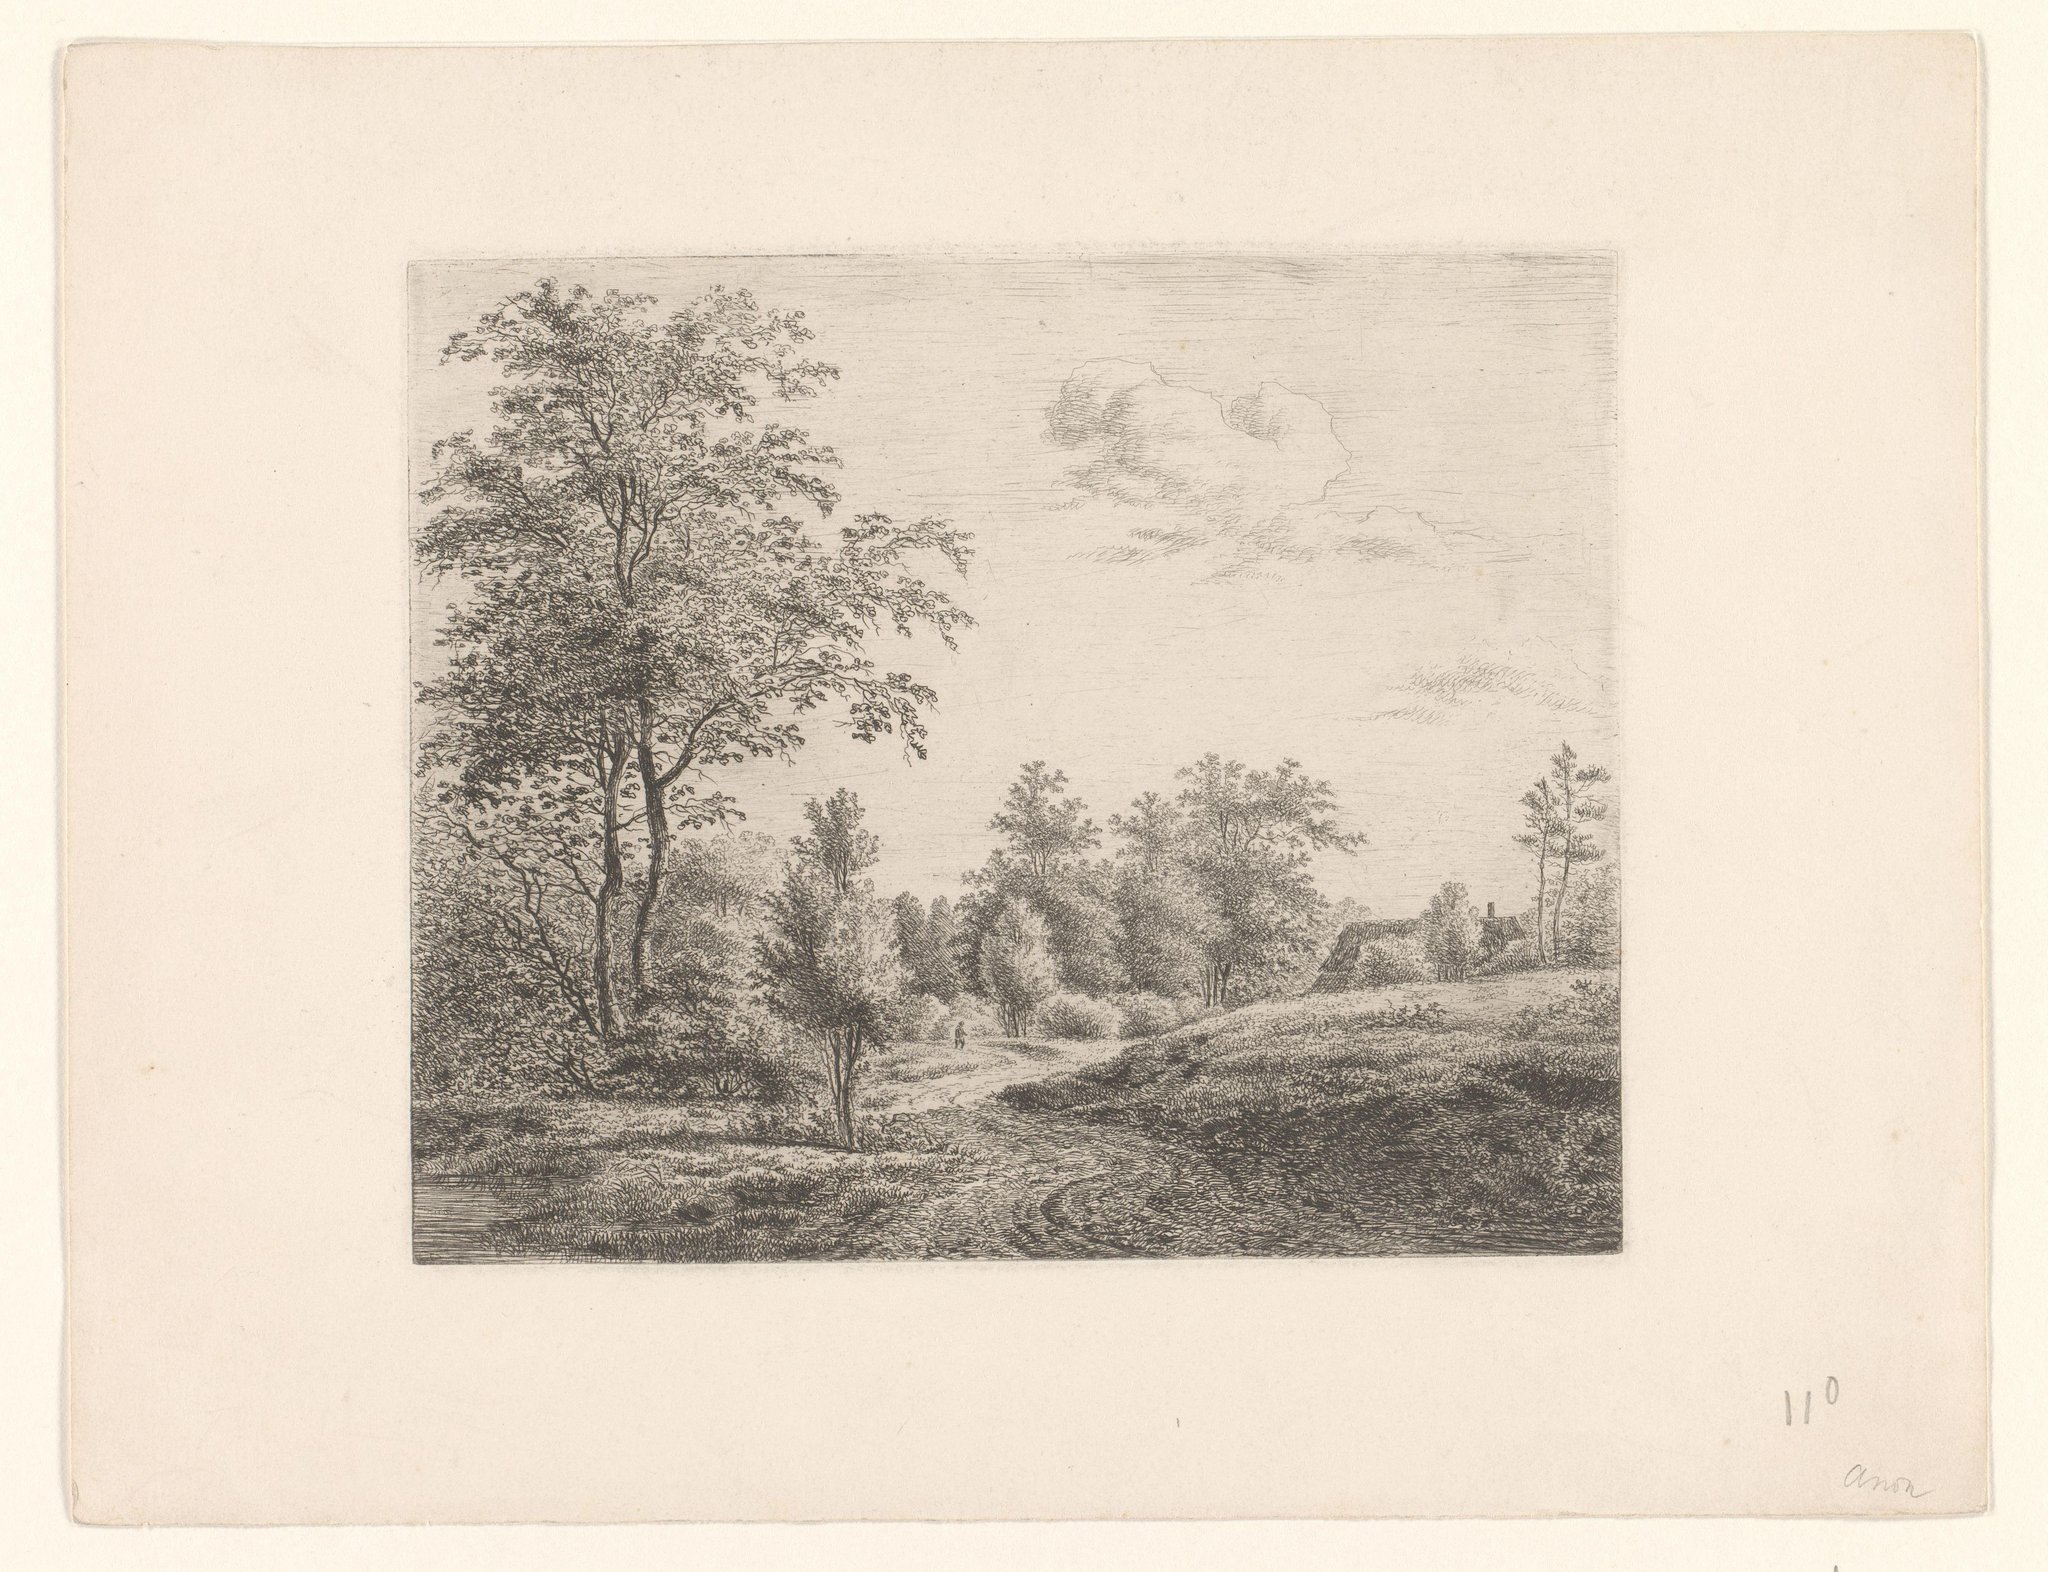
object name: print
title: Landschap met pad aan de rand van een bos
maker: Anonymous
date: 1800-1899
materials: paper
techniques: etching, intaglio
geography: france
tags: barn, fringe, edge of the wood, forest path or lane (+ landscape with figures, staffage)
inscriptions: collector's mark: Lugt 2228